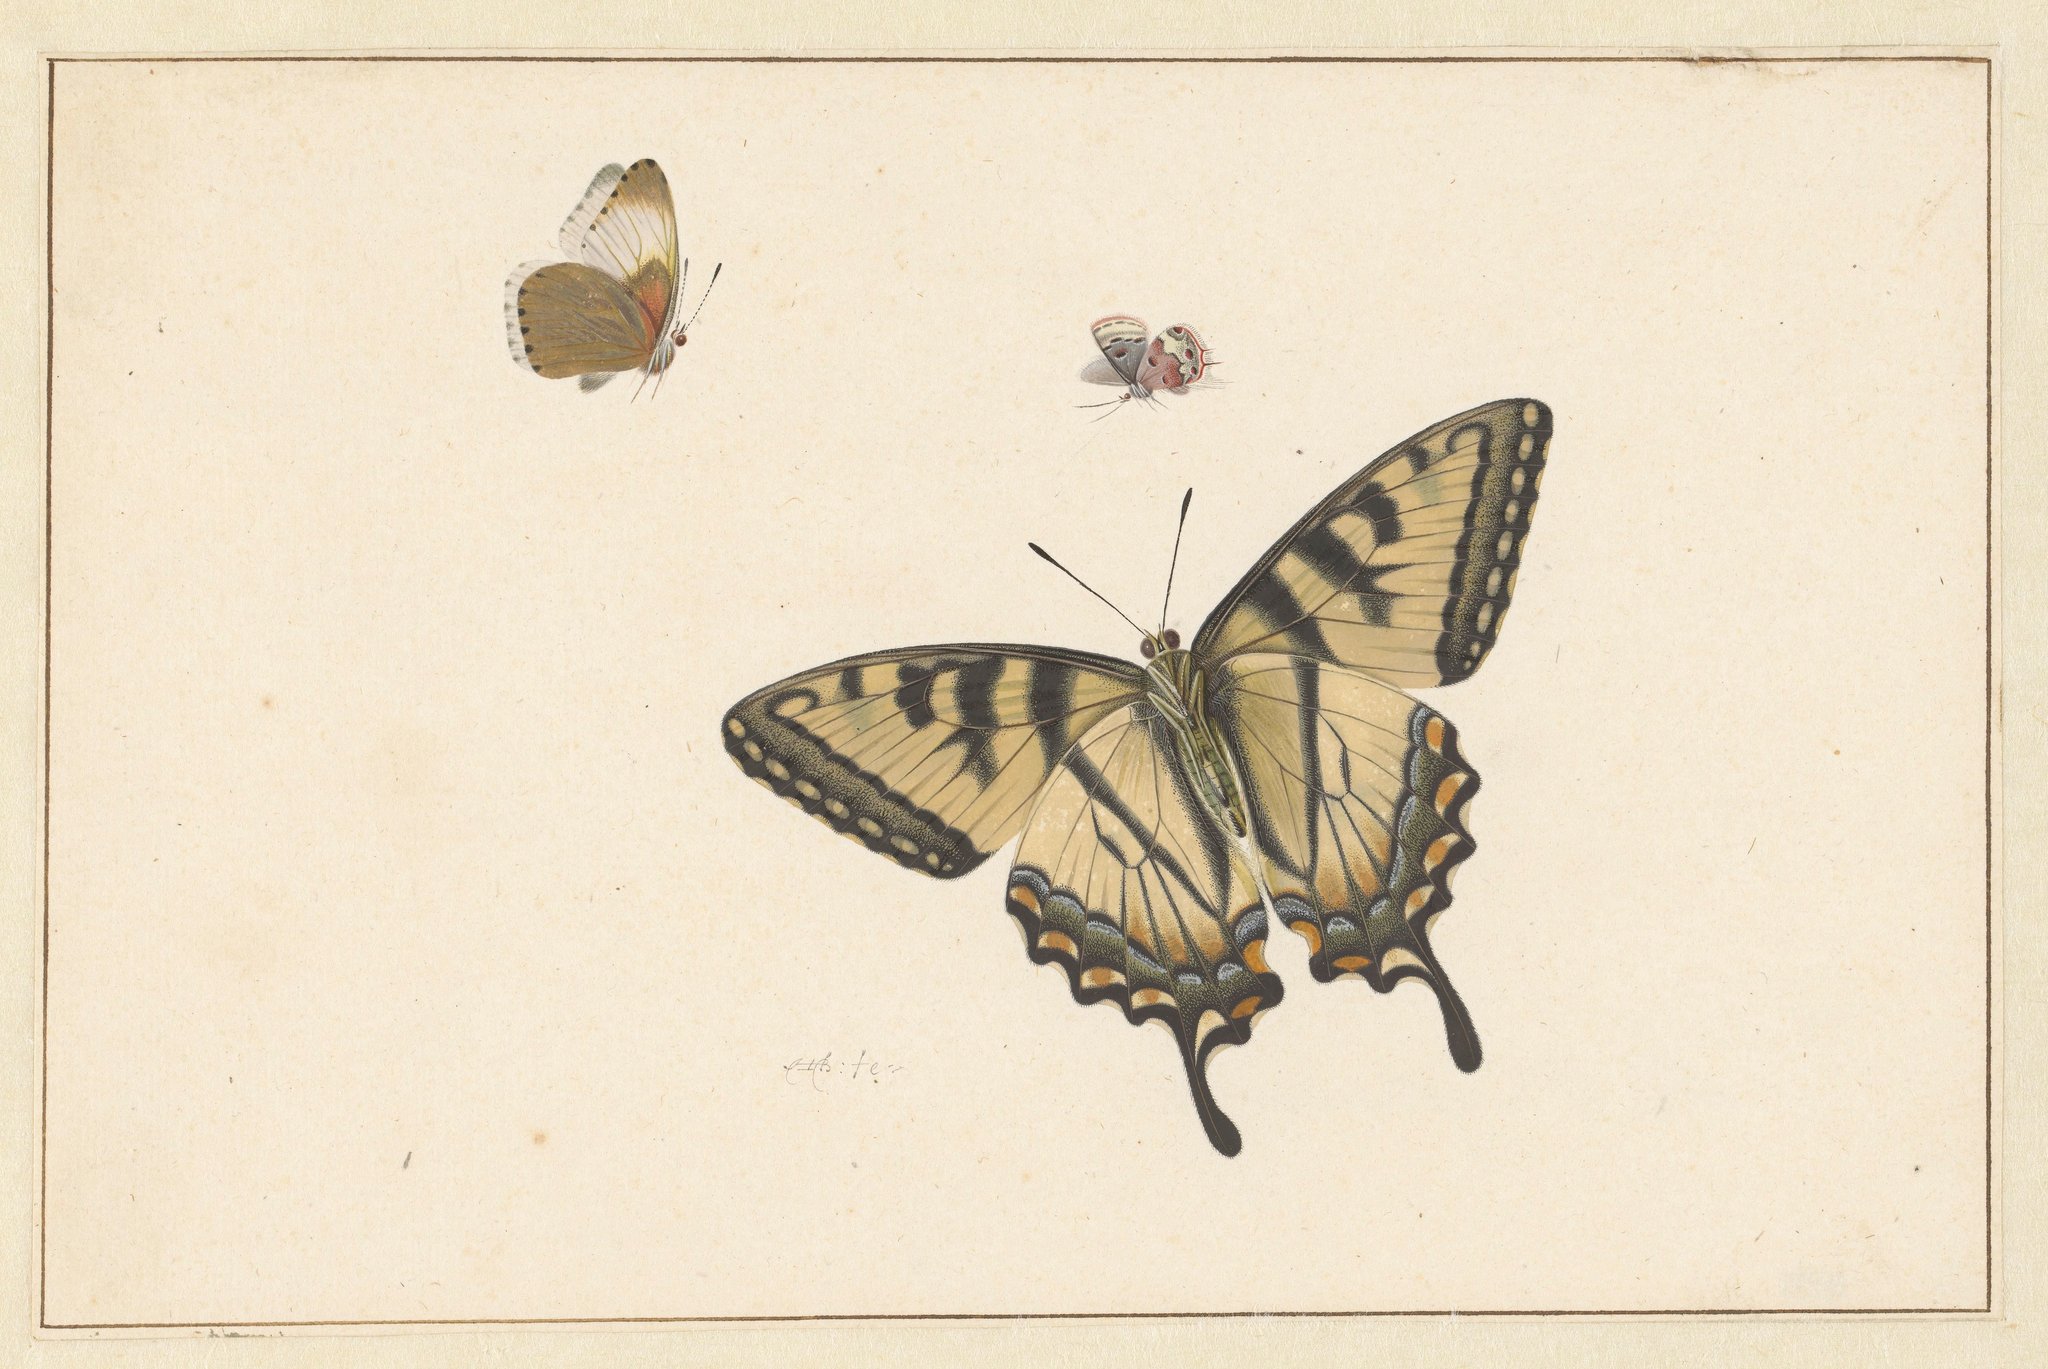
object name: drawing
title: Three Butterflies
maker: herman henstenburgh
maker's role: draughtsman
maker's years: 1667-1726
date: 1683-1726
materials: paint, gouache, paper, watercolor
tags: insects: butterfly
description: Herman Henstenburgh from Hoorn often embellished his floral still lifes with butterflies and insects. Sometimes he also drew them separately, as in this drawing of a life-sized swallowtail (Papilio glaucus). This butterfly from the Papilionidae family, recognizable by the tiger-stripe markings on its wings, can reach a wingspan measuring between 80 and 140 millimetres.